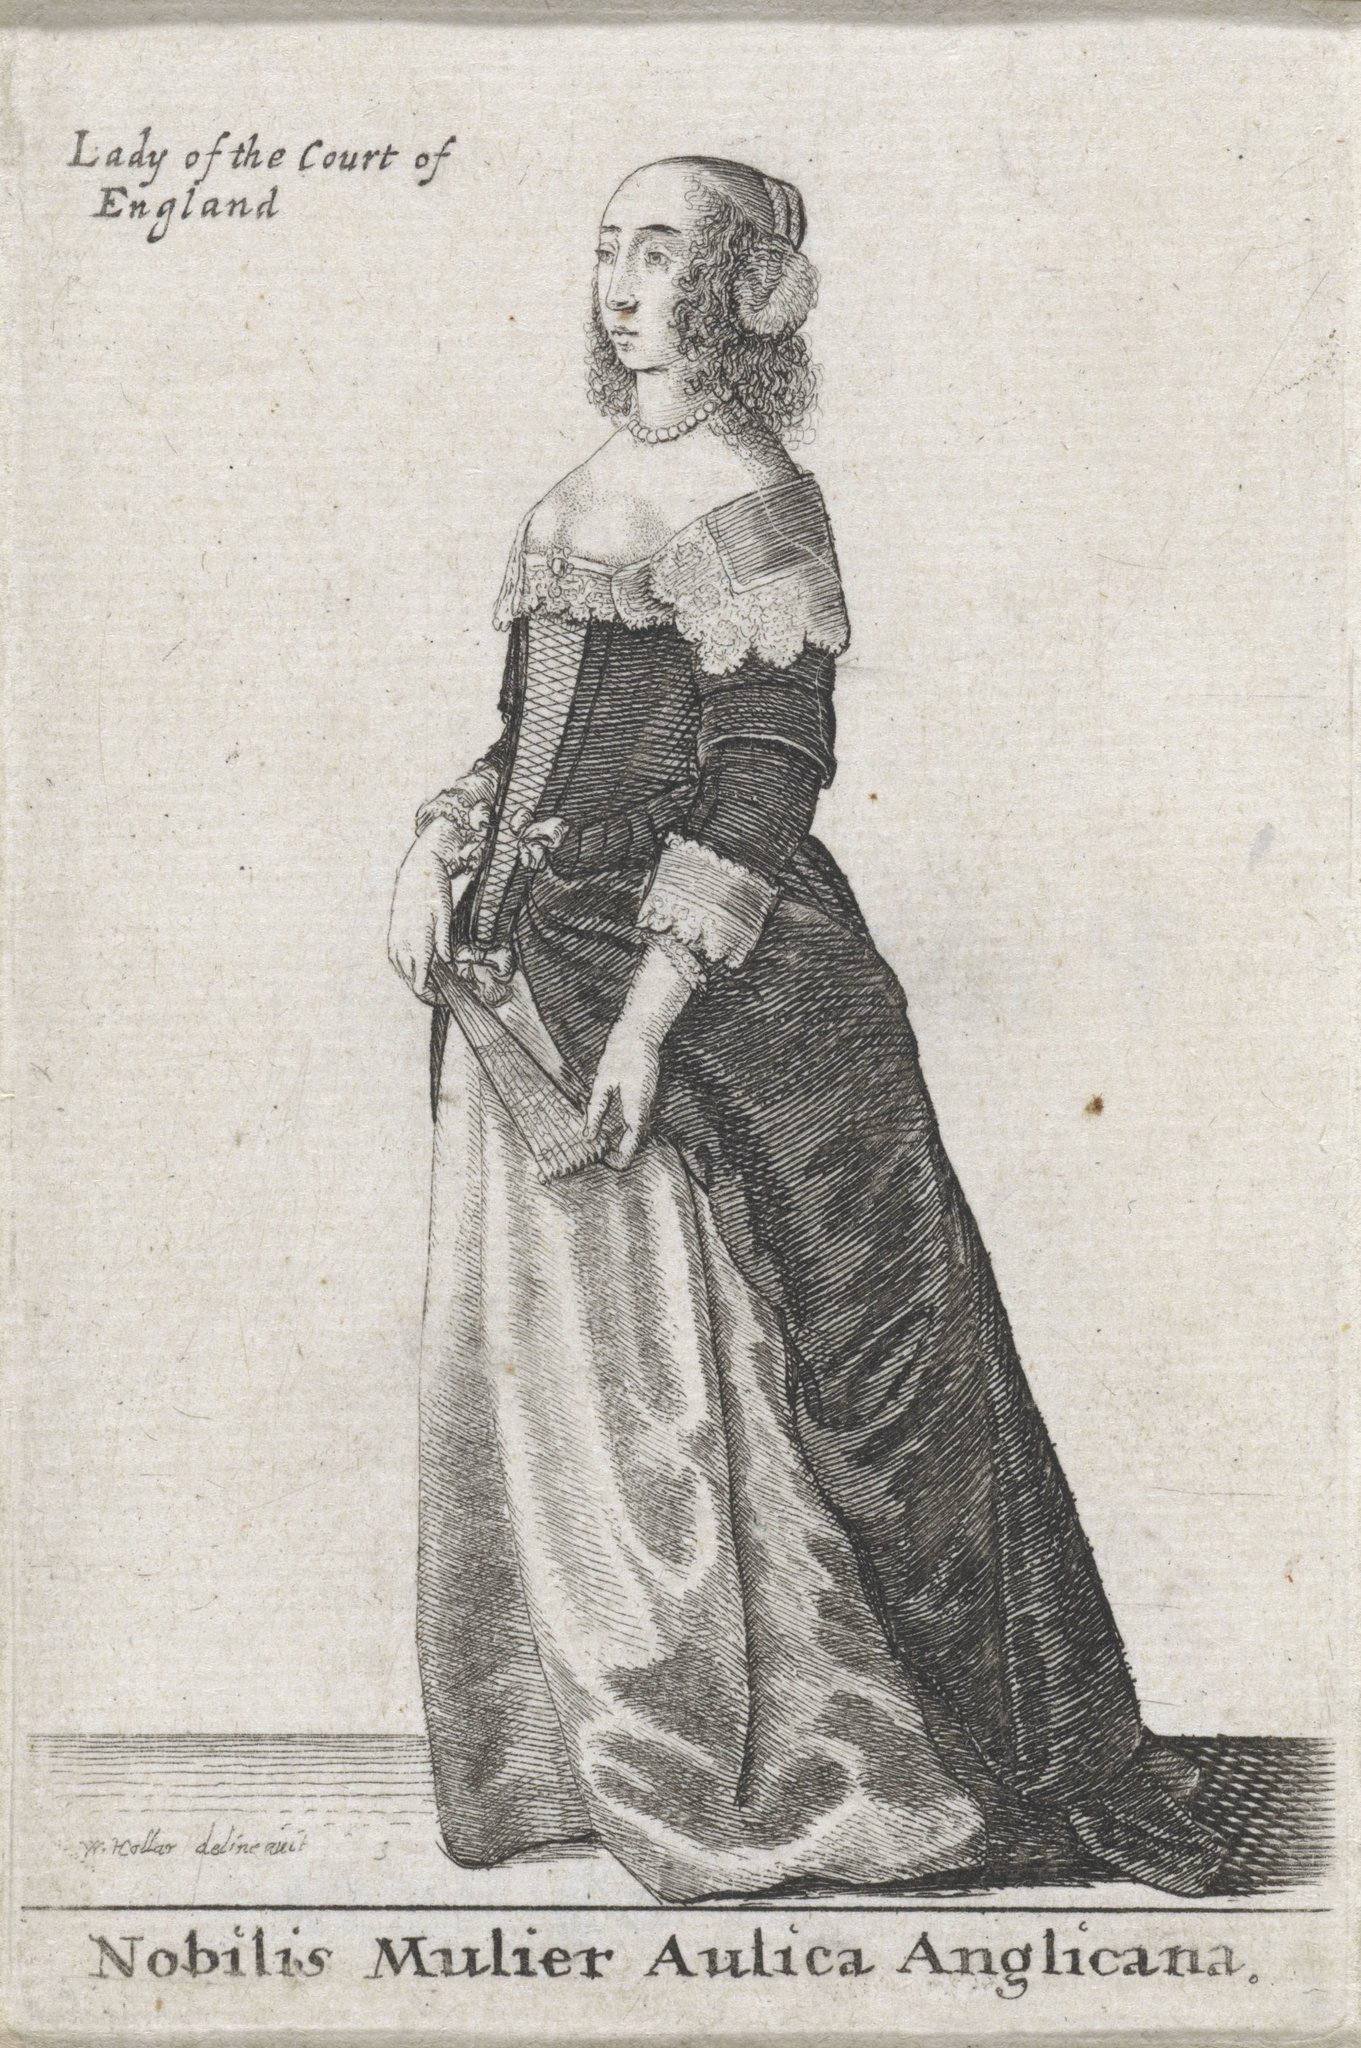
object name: costume print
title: Theatrum Mulierum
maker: wenceslaus hollar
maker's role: draughtsman, print maker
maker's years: 1607-1677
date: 1643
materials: paper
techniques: etching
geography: london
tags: skirt (underskirt) (+ women's clothes), styles of hairdress - aa - ~ women, europeans: englishmen (+ costume), neck-gear: collar (+ women's clothes), skirt (+ women's clothes), sleeves: cuffs (+ women's clothes), dress, gown (+ women's clothes), fan (+ women's clothes), sleeves (+ women's clothes), clothing for the upper part of the body (with name) (+ women's clothes), pearl; pearl necklace (+ women's clothes), england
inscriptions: collector's mark: Lugt 240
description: Hofdame uit Engeland, staand naar links. Kapsel met losvallend krullend haar opzij, op het achterhoofd in een knotje gedraaid, versierd met een veer. Donker lijfje met decolleté, gegarneerd met kant, donker overkleed en lichte onderrok. Parelsnoer (kralensnoer?) om de hals, een gesloten vouwwaaier in de handen.